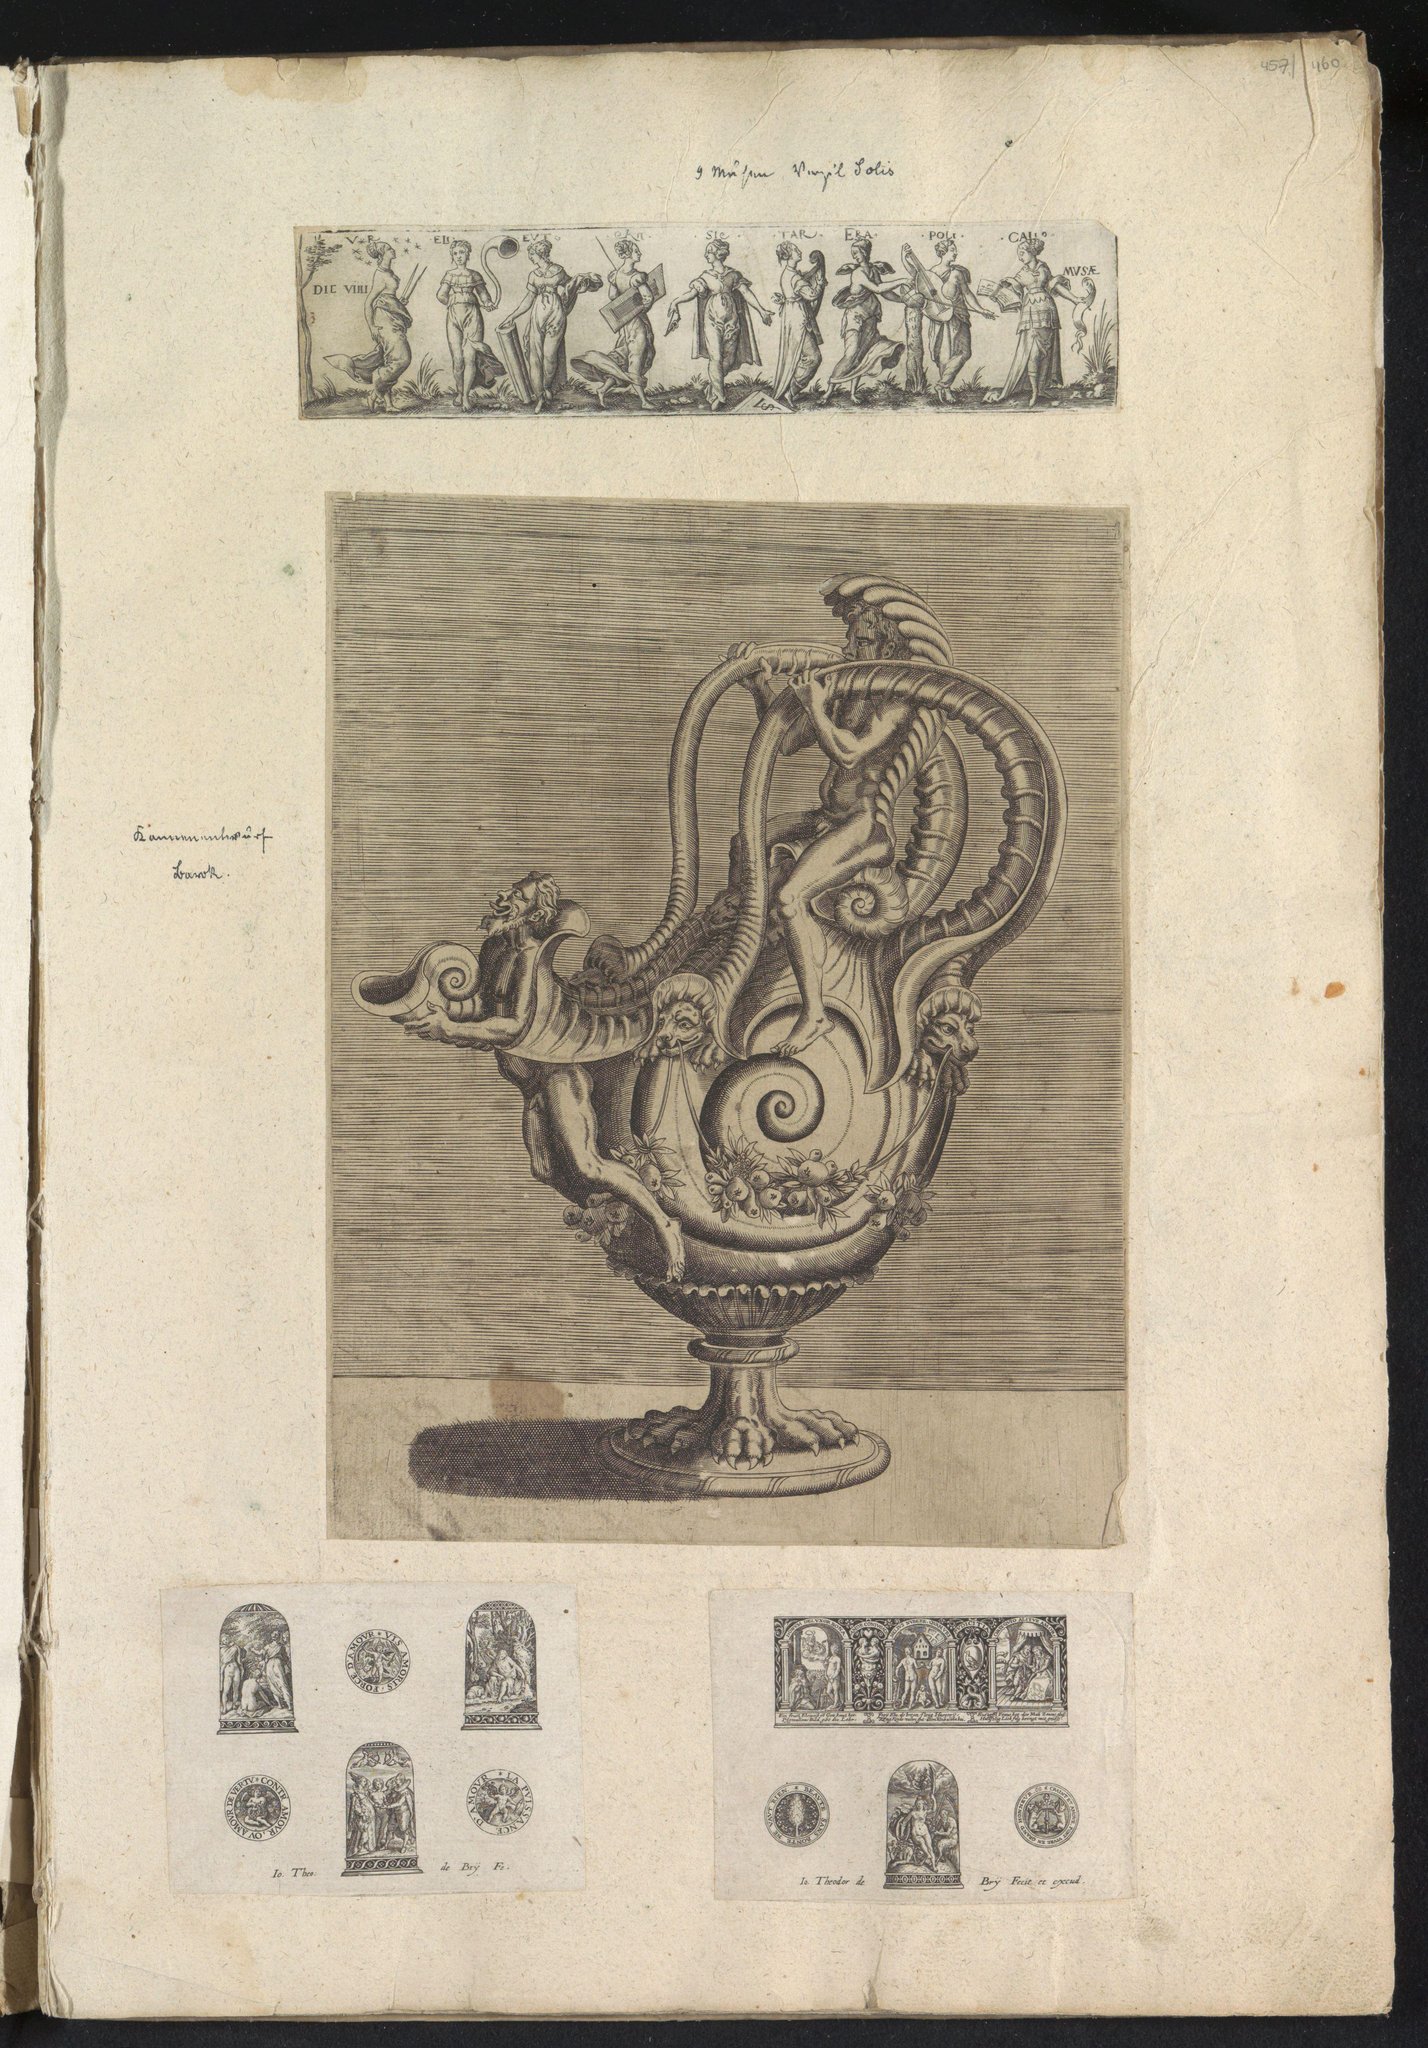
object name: ornament print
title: Albumblad met vier prenten met vingerhoedjes met Bijbelverhalen, een kan en de muzen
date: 1500-1699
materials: paper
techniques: engraving, etching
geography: low countries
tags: kitchen-utensils: cauldron, thimble, (story of the) muses; 'muse' (ripa), saints, the muses acting together (as group)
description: Albumblad met vier uitgeknipte prenten: ontwerpen voor vingerhoedjes met voorstellingen van heiligen en Bijbelverhalen, een ornamentele kan en de muzen op een rij.